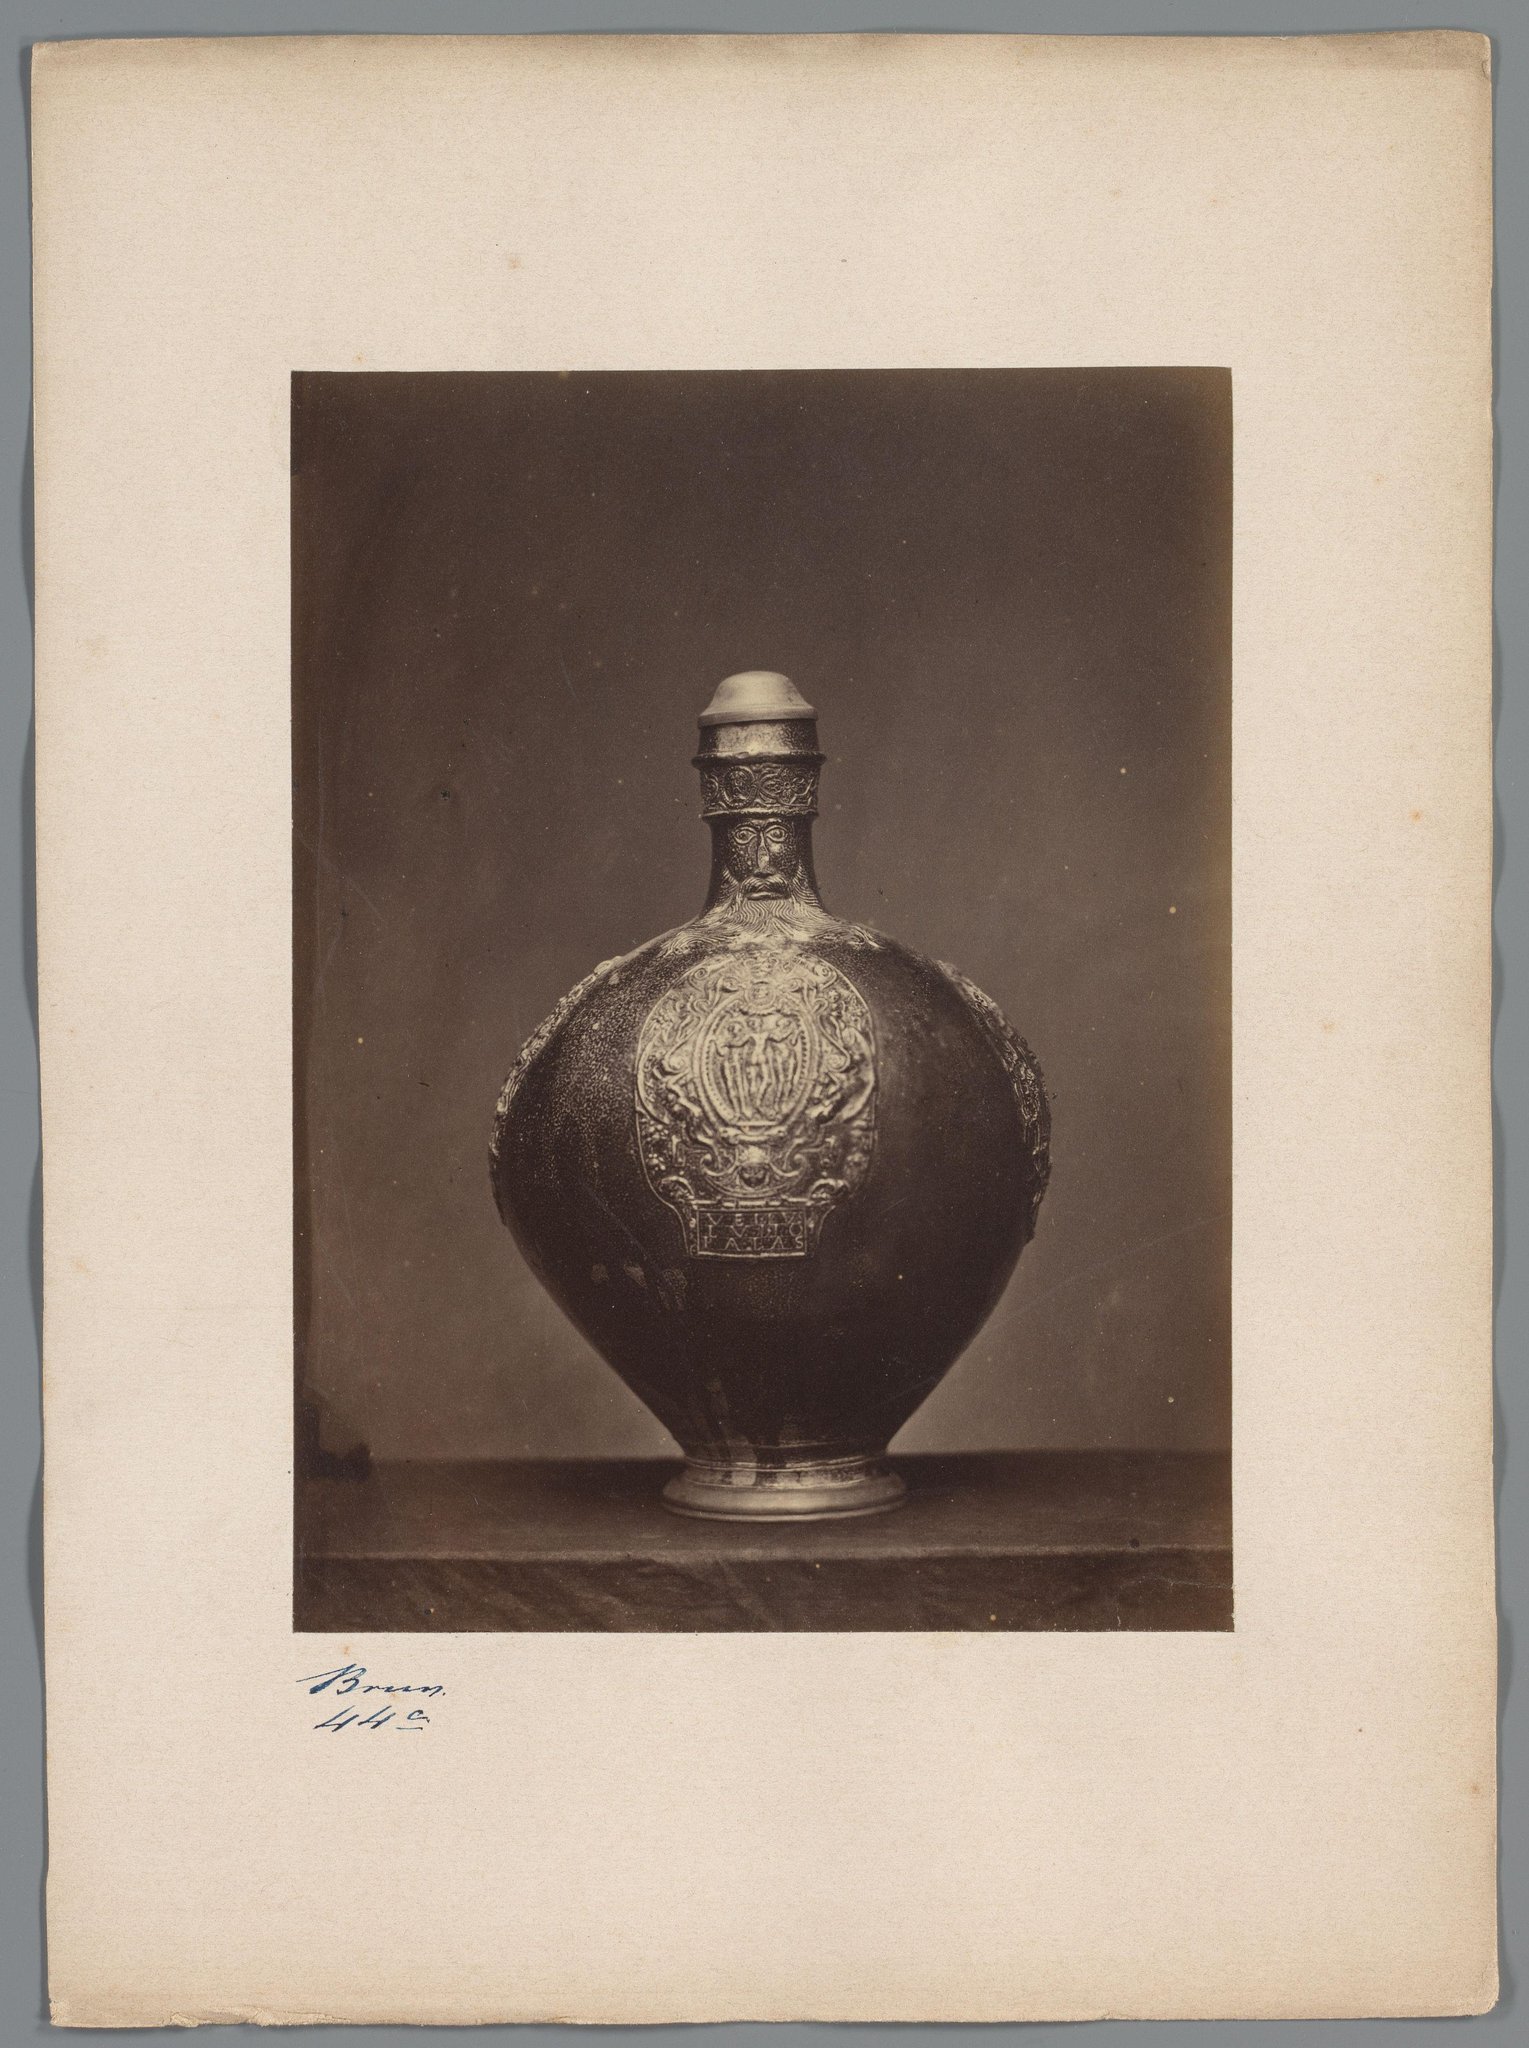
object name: photograph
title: Aardewerken vaas uit de collectie van W. de Weckherlin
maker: Anonymous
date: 1860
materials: paper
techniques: albumen print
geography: the hague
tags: container of ceramics: jar, jug, pot, vase, the hague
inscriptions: inscription: ‘Brun/ 44c’